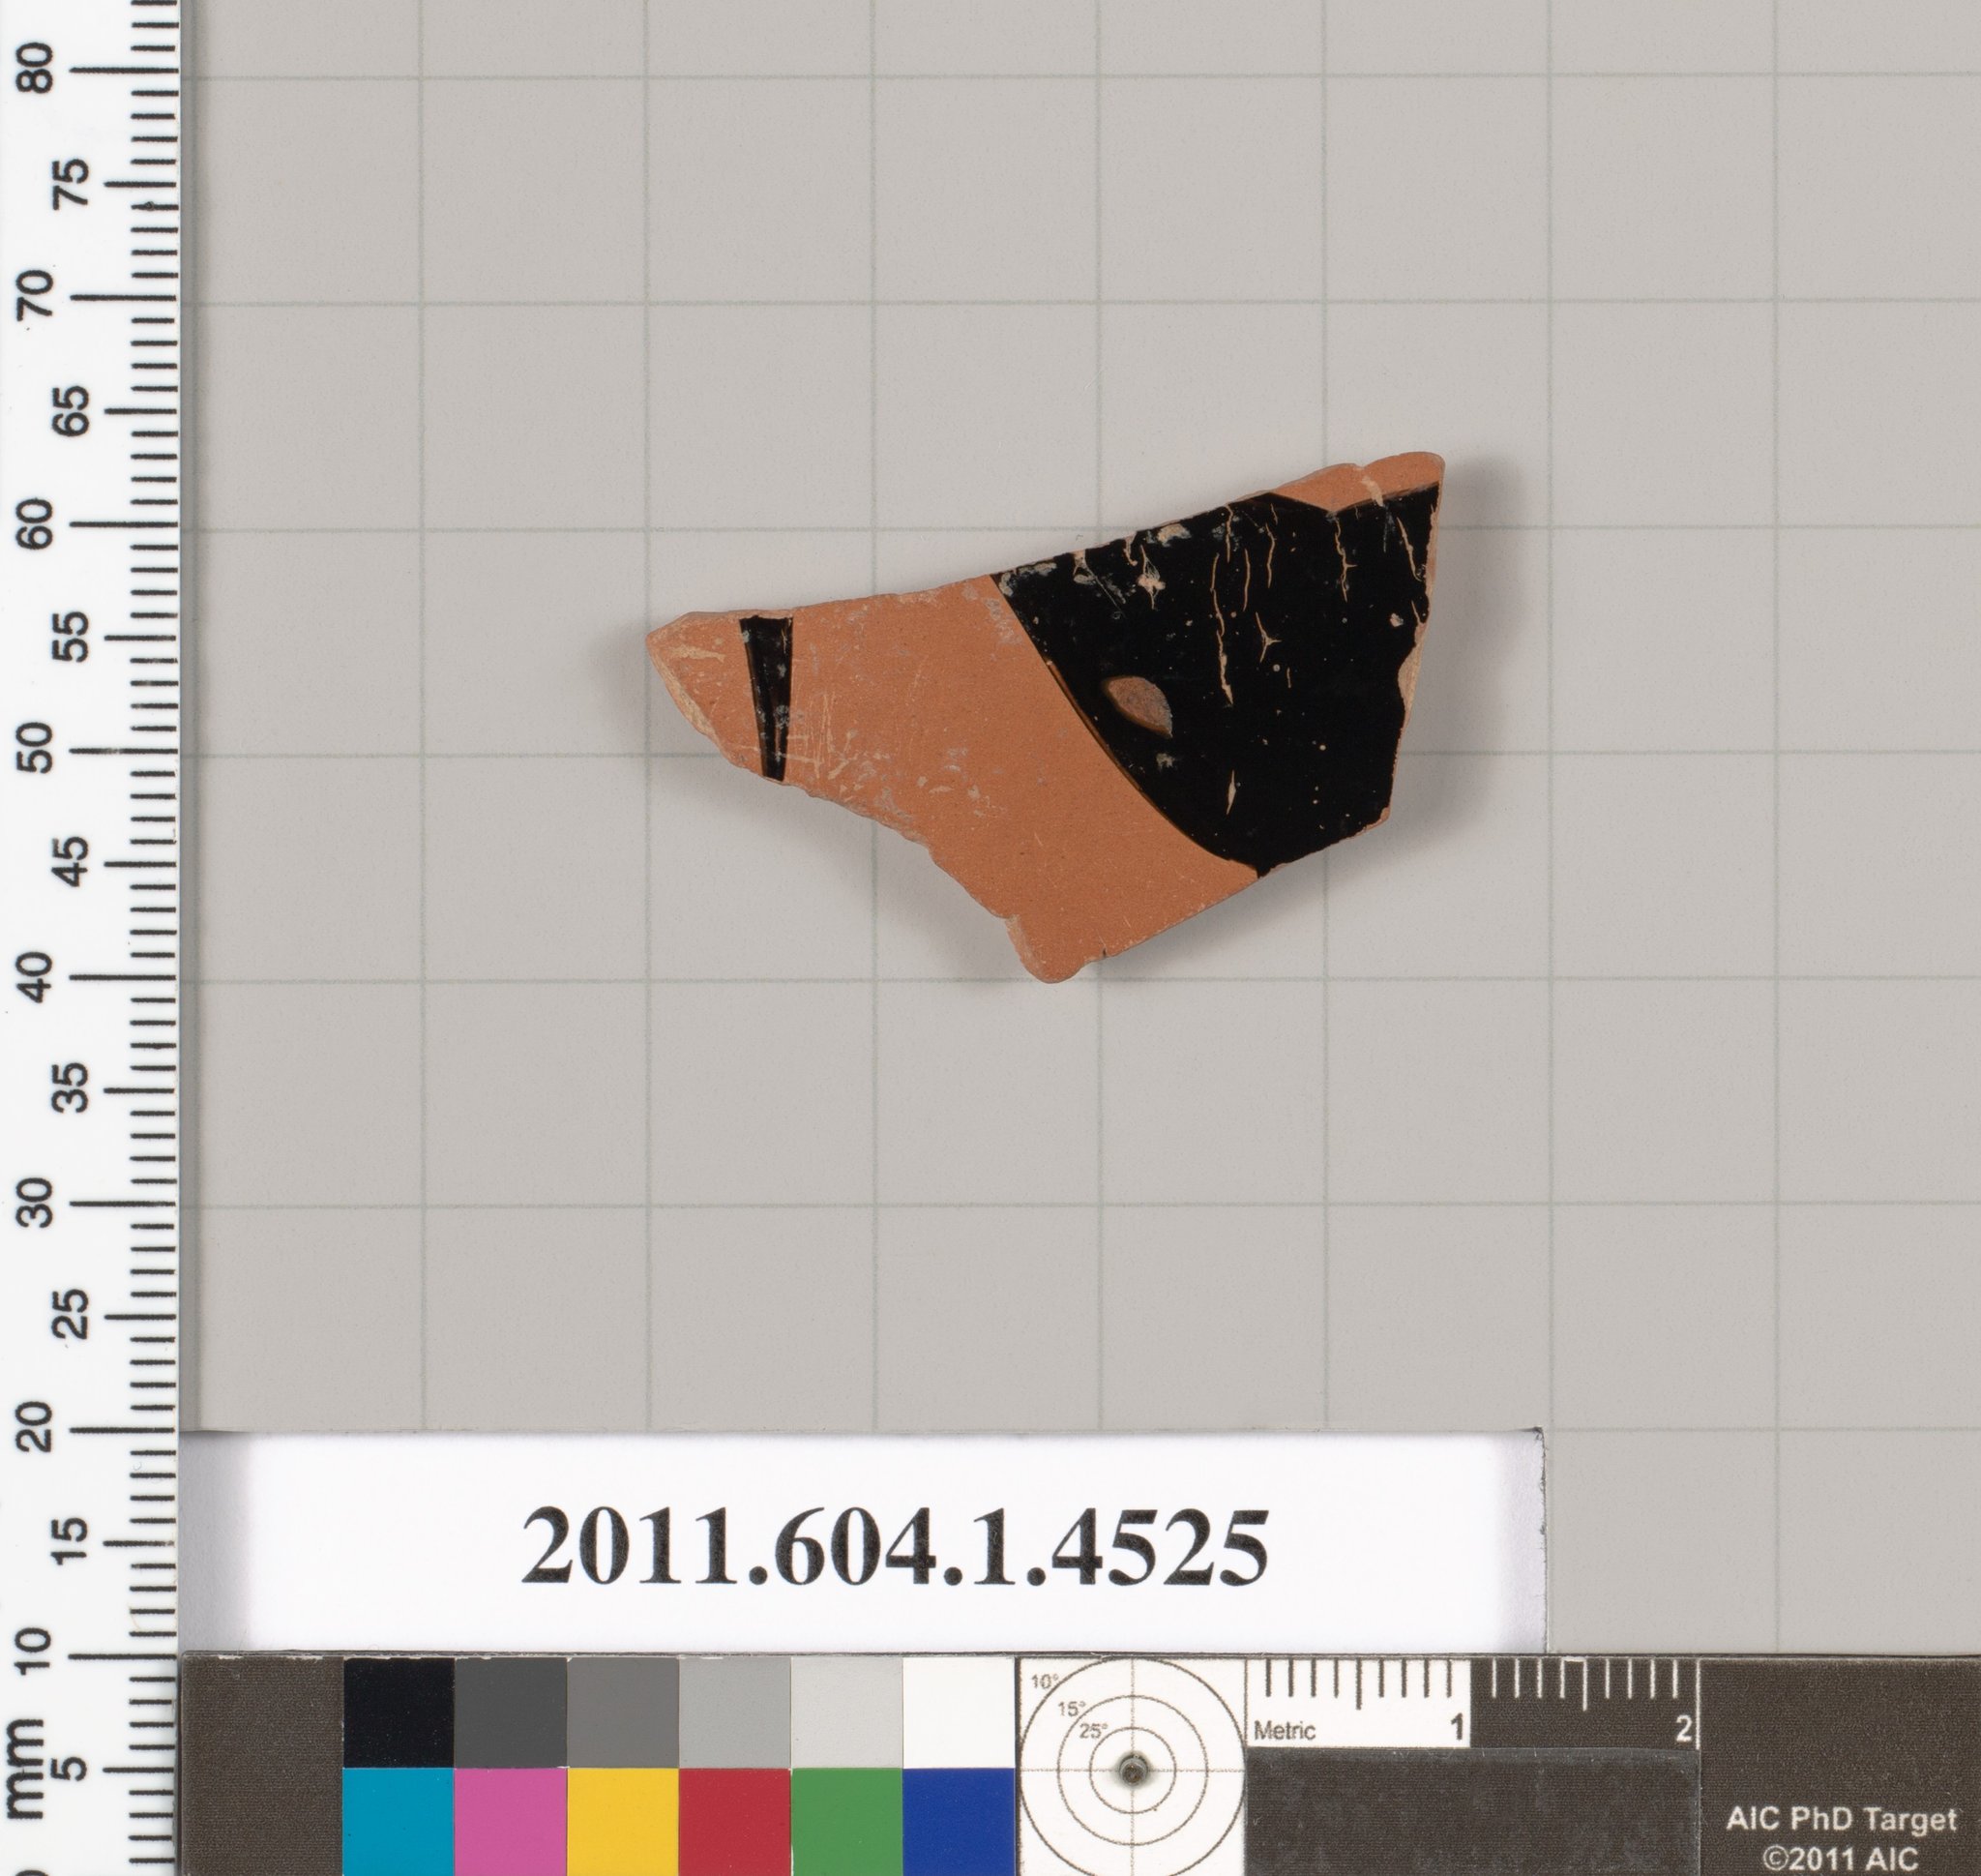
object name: kylix fragment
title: Terracotta fragment of a kylix (drinking cup)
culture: greek, attic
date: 534-468 BCE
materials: terracotta